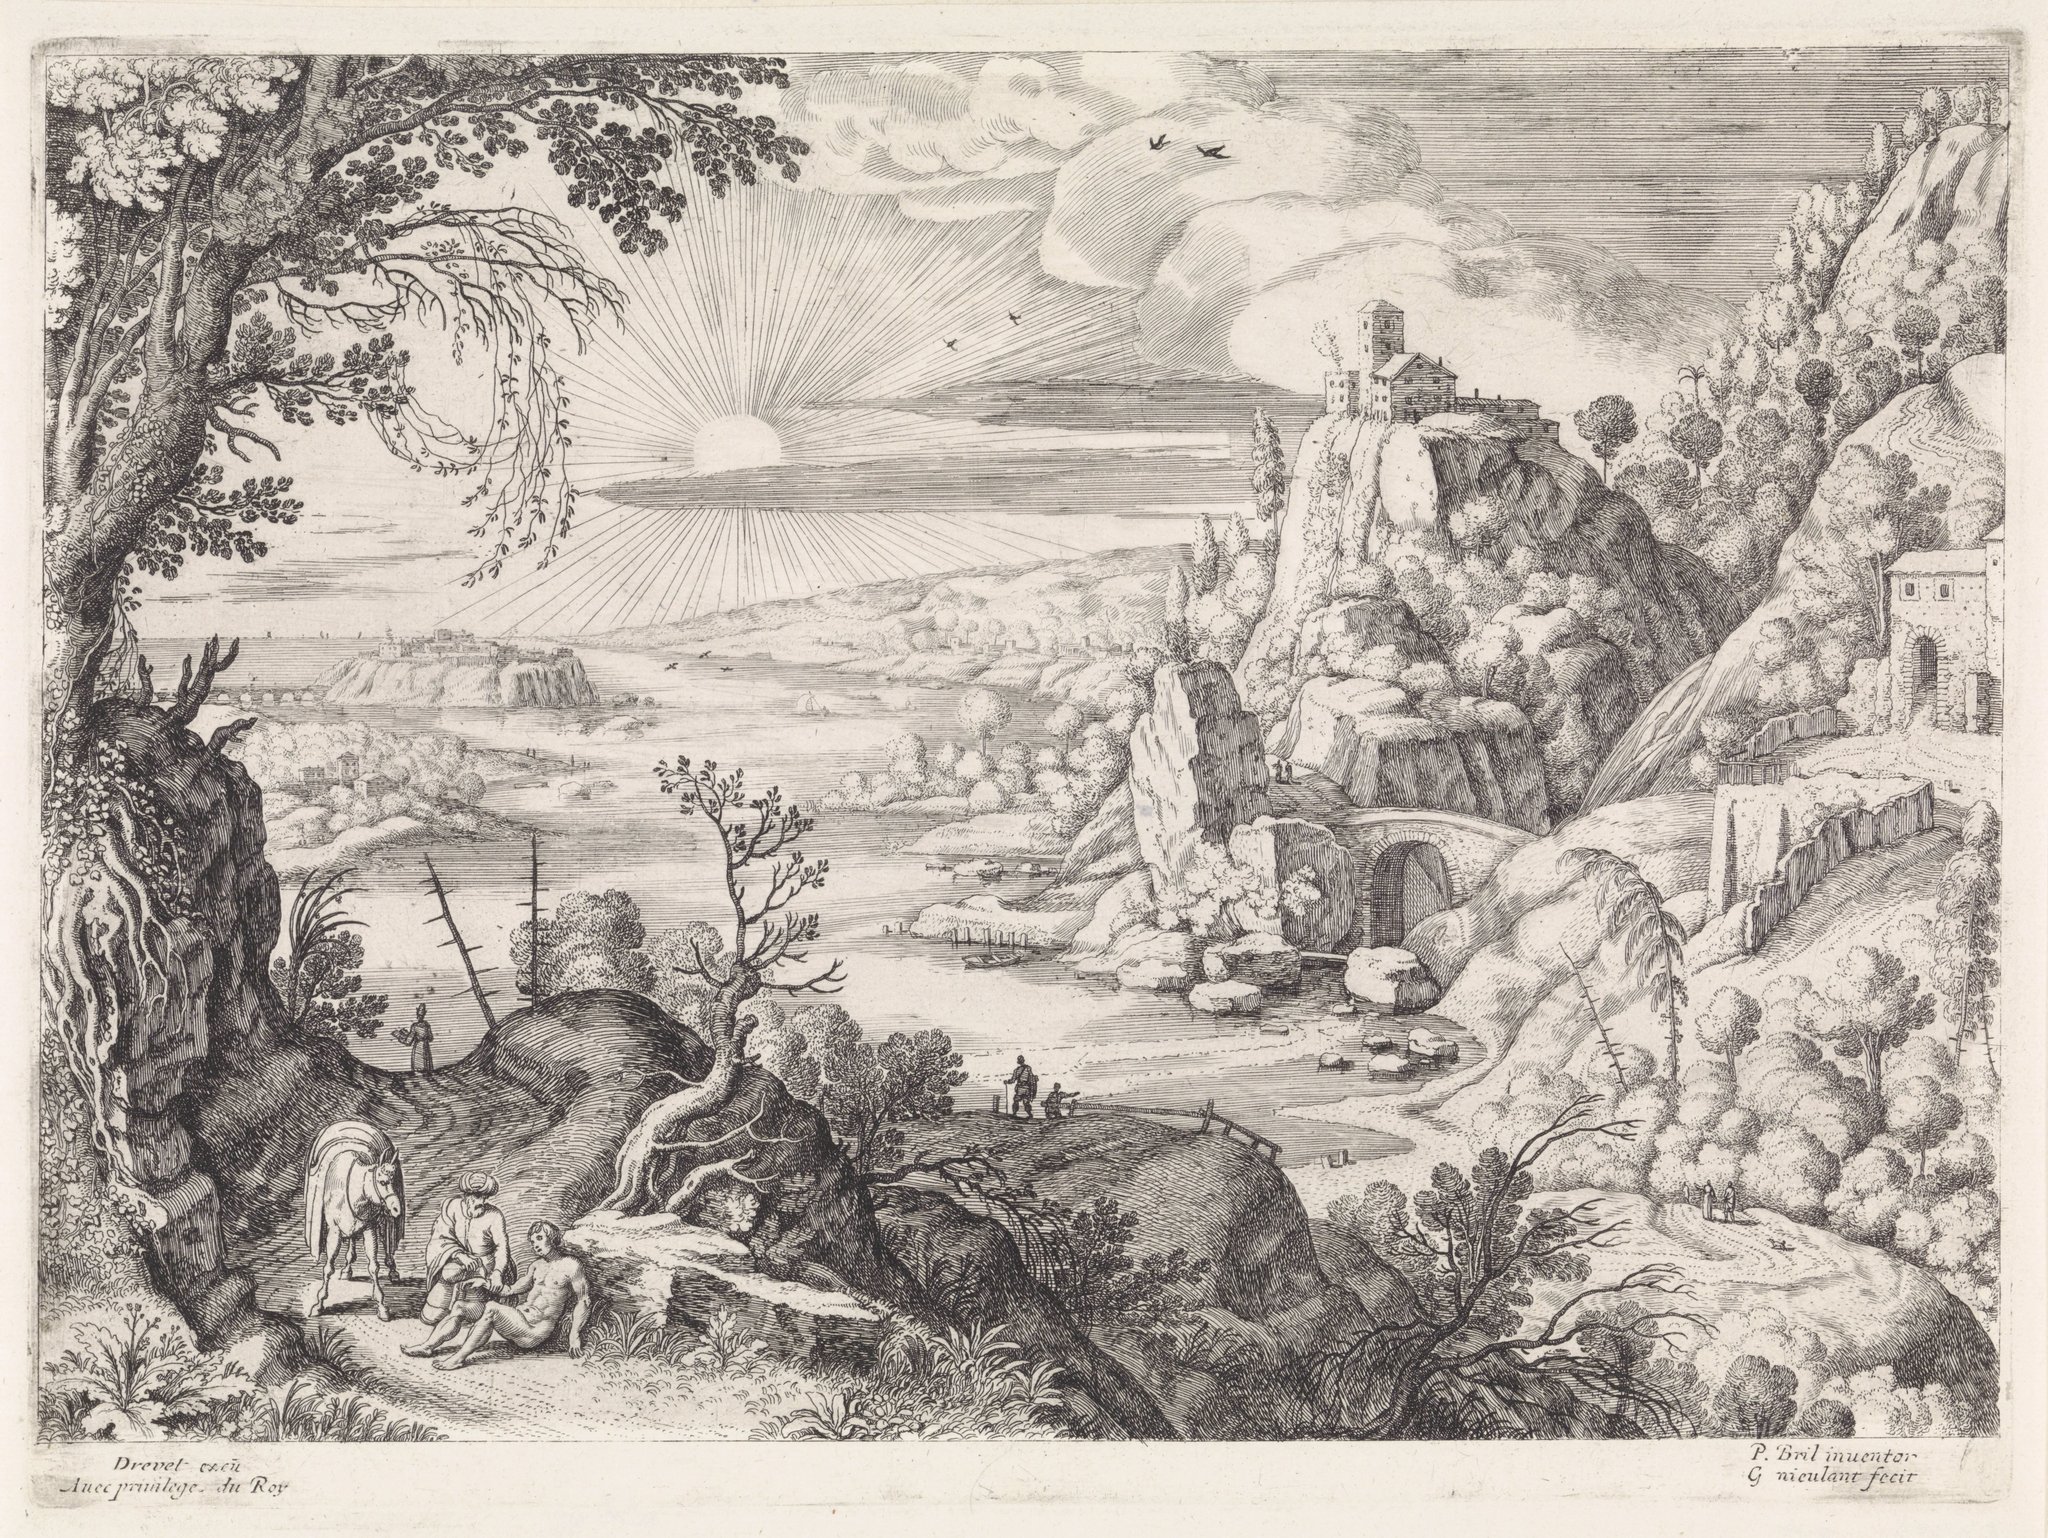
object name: print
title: Landschap met de barmhartige Samaritaan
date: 1594-1635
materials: paper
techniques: engraving, etching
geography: france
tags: landscapes in the temperate zone, a samaritan tending the wounds of the traveller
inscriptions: collector's mark: Lugt 2228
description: In een Italiaans kustlandschap verzorgt de barmhartige Samaritaan de gewonde reiziger. Naast hen staat de ezel van de Samaritaan. Naar het Bijbelverhaal uit Luc. 10: 25-37.